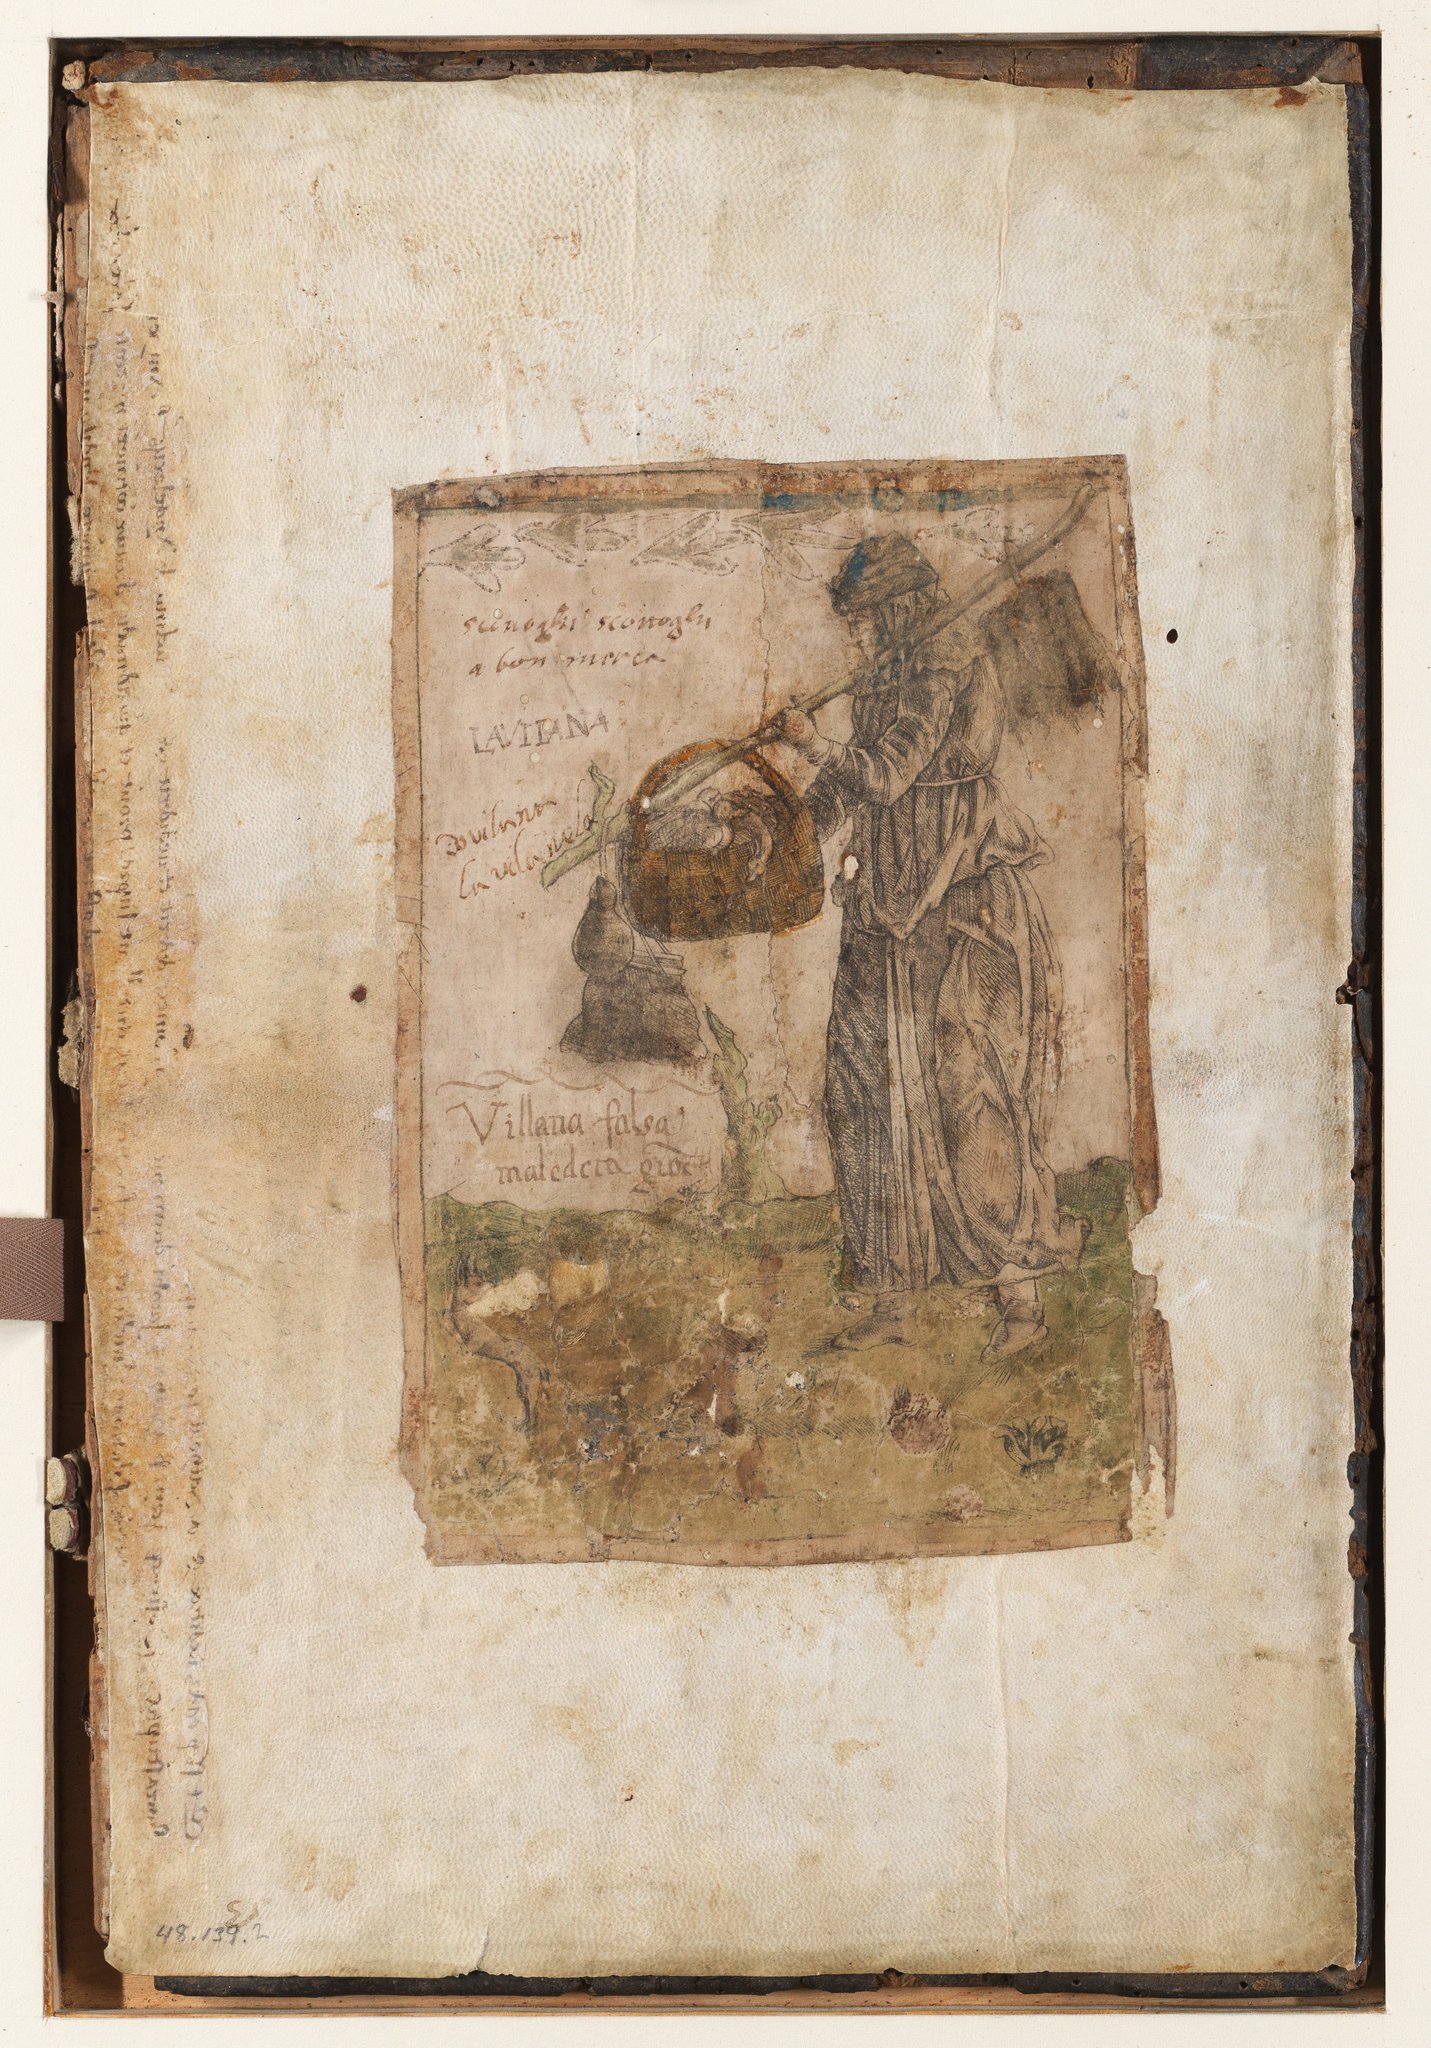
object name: print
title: A peasant woman going to market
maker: anonymous, italian, 15th century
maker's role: artist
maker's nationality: italian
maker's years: 1400-1500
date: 1470-1480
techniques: engraving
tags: women